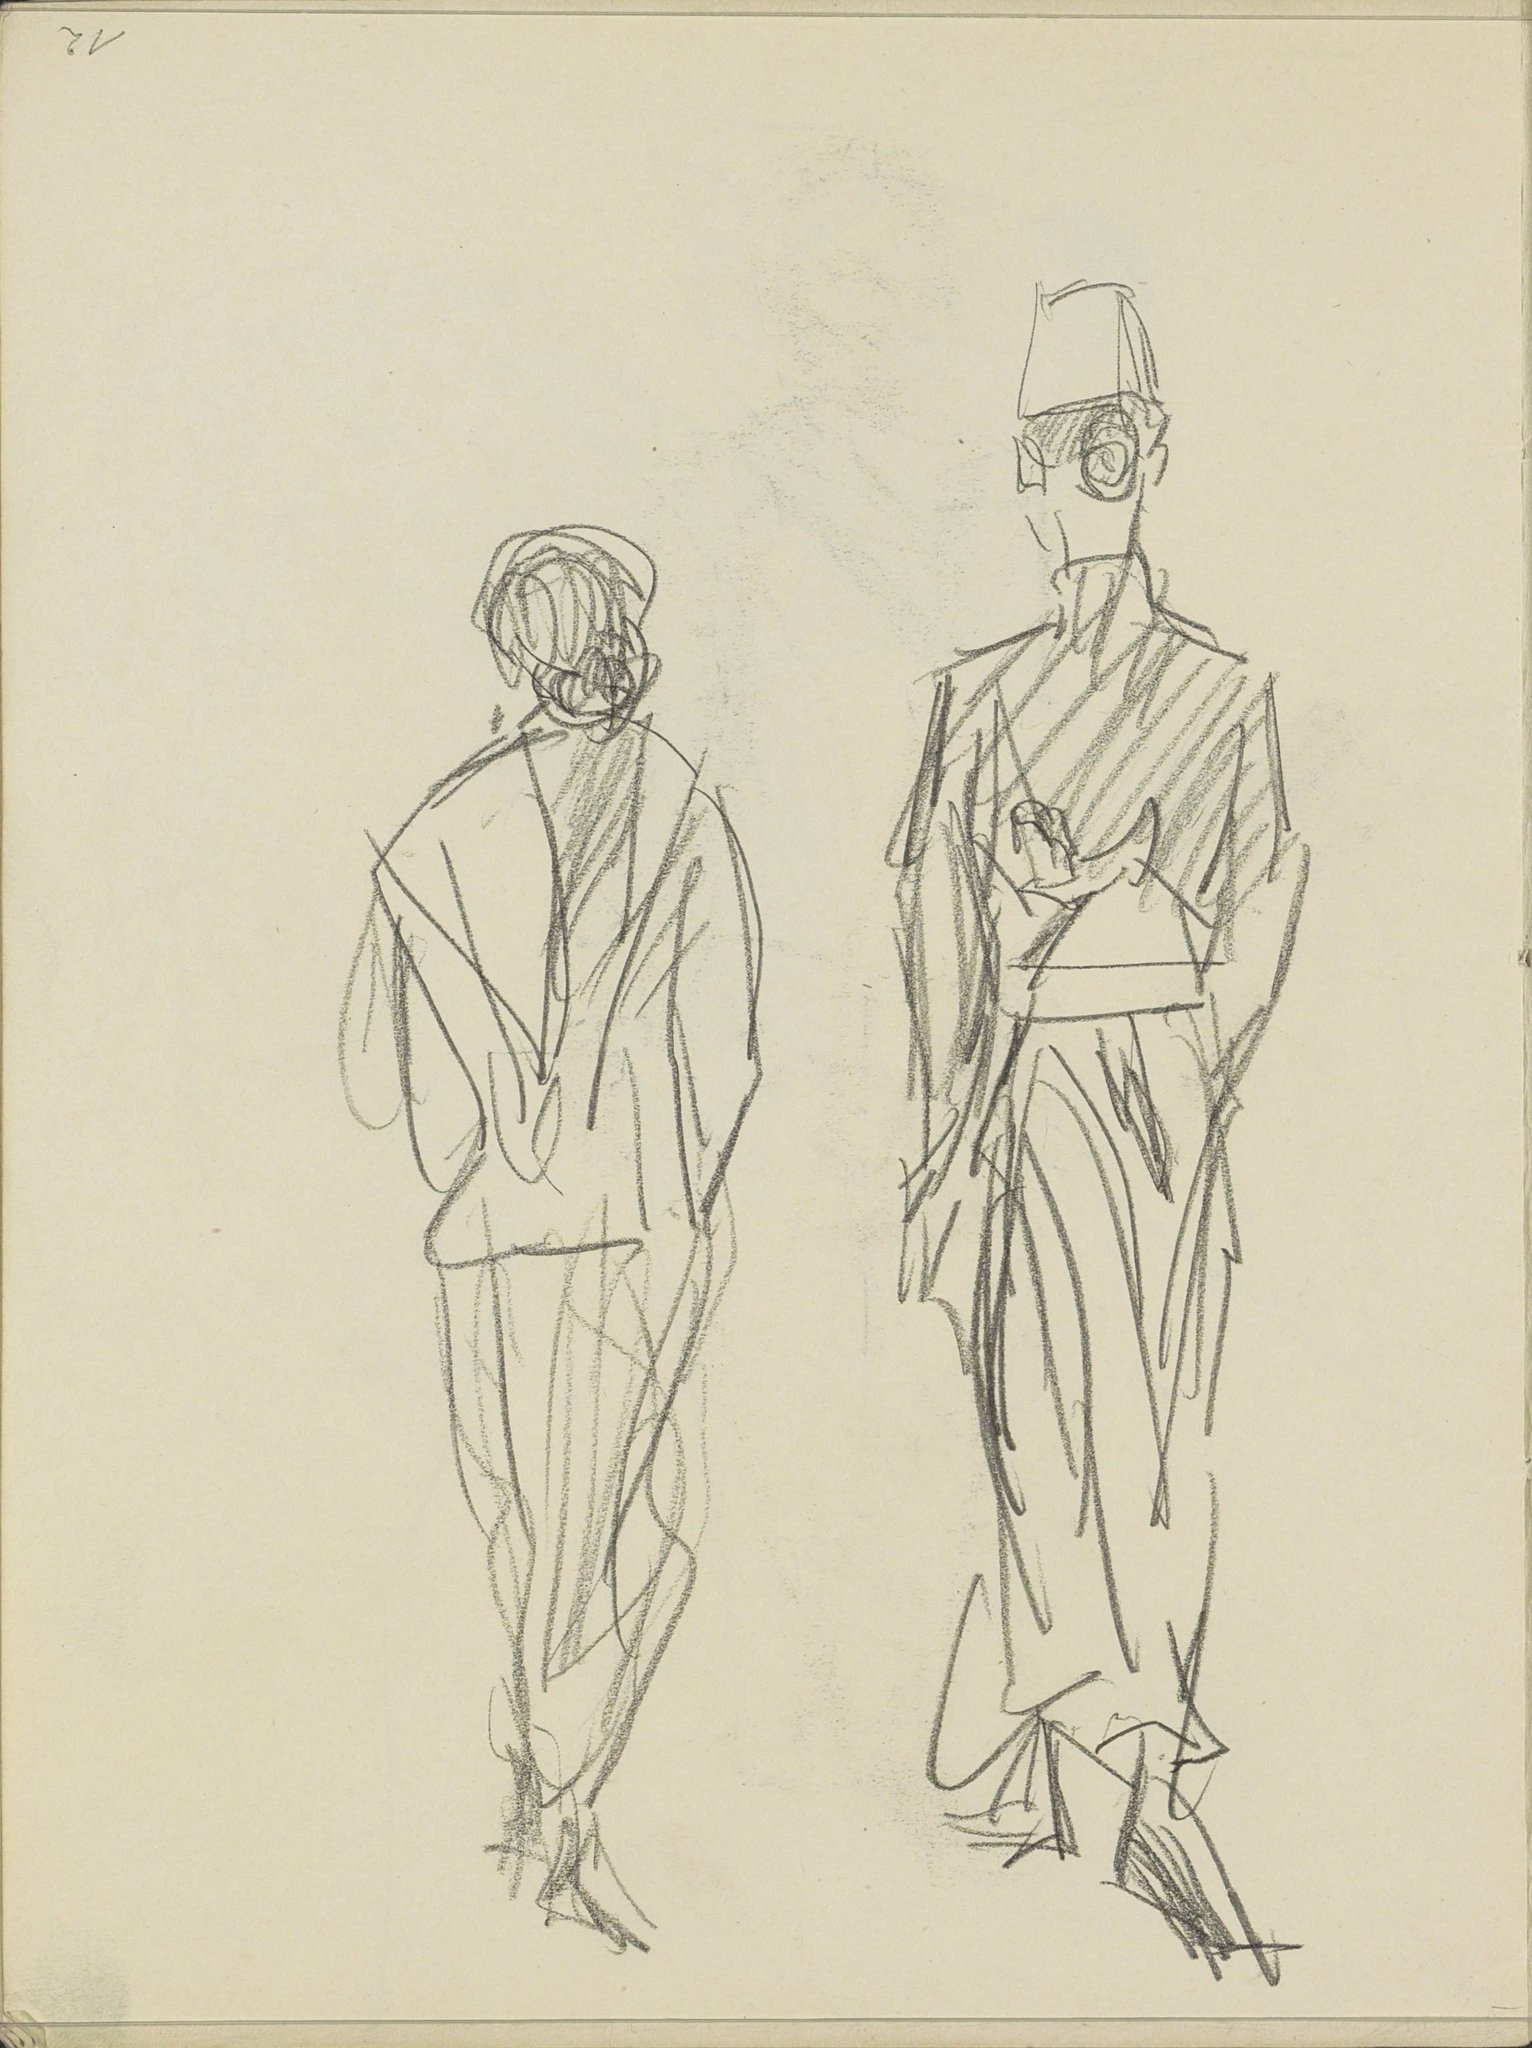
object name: sketchbook leaf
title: Staande vrouw en man met fez, op de rug gezien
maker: isaac israels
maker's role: draughtsman, painter, print maker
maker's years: 1865-1934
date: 1875-1934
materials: paper, pencil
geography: the hague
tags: adult woman (+ standing), adult man (+ standing)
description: Blad 9 verso uit schetsboek XXIV met 10 bladen.